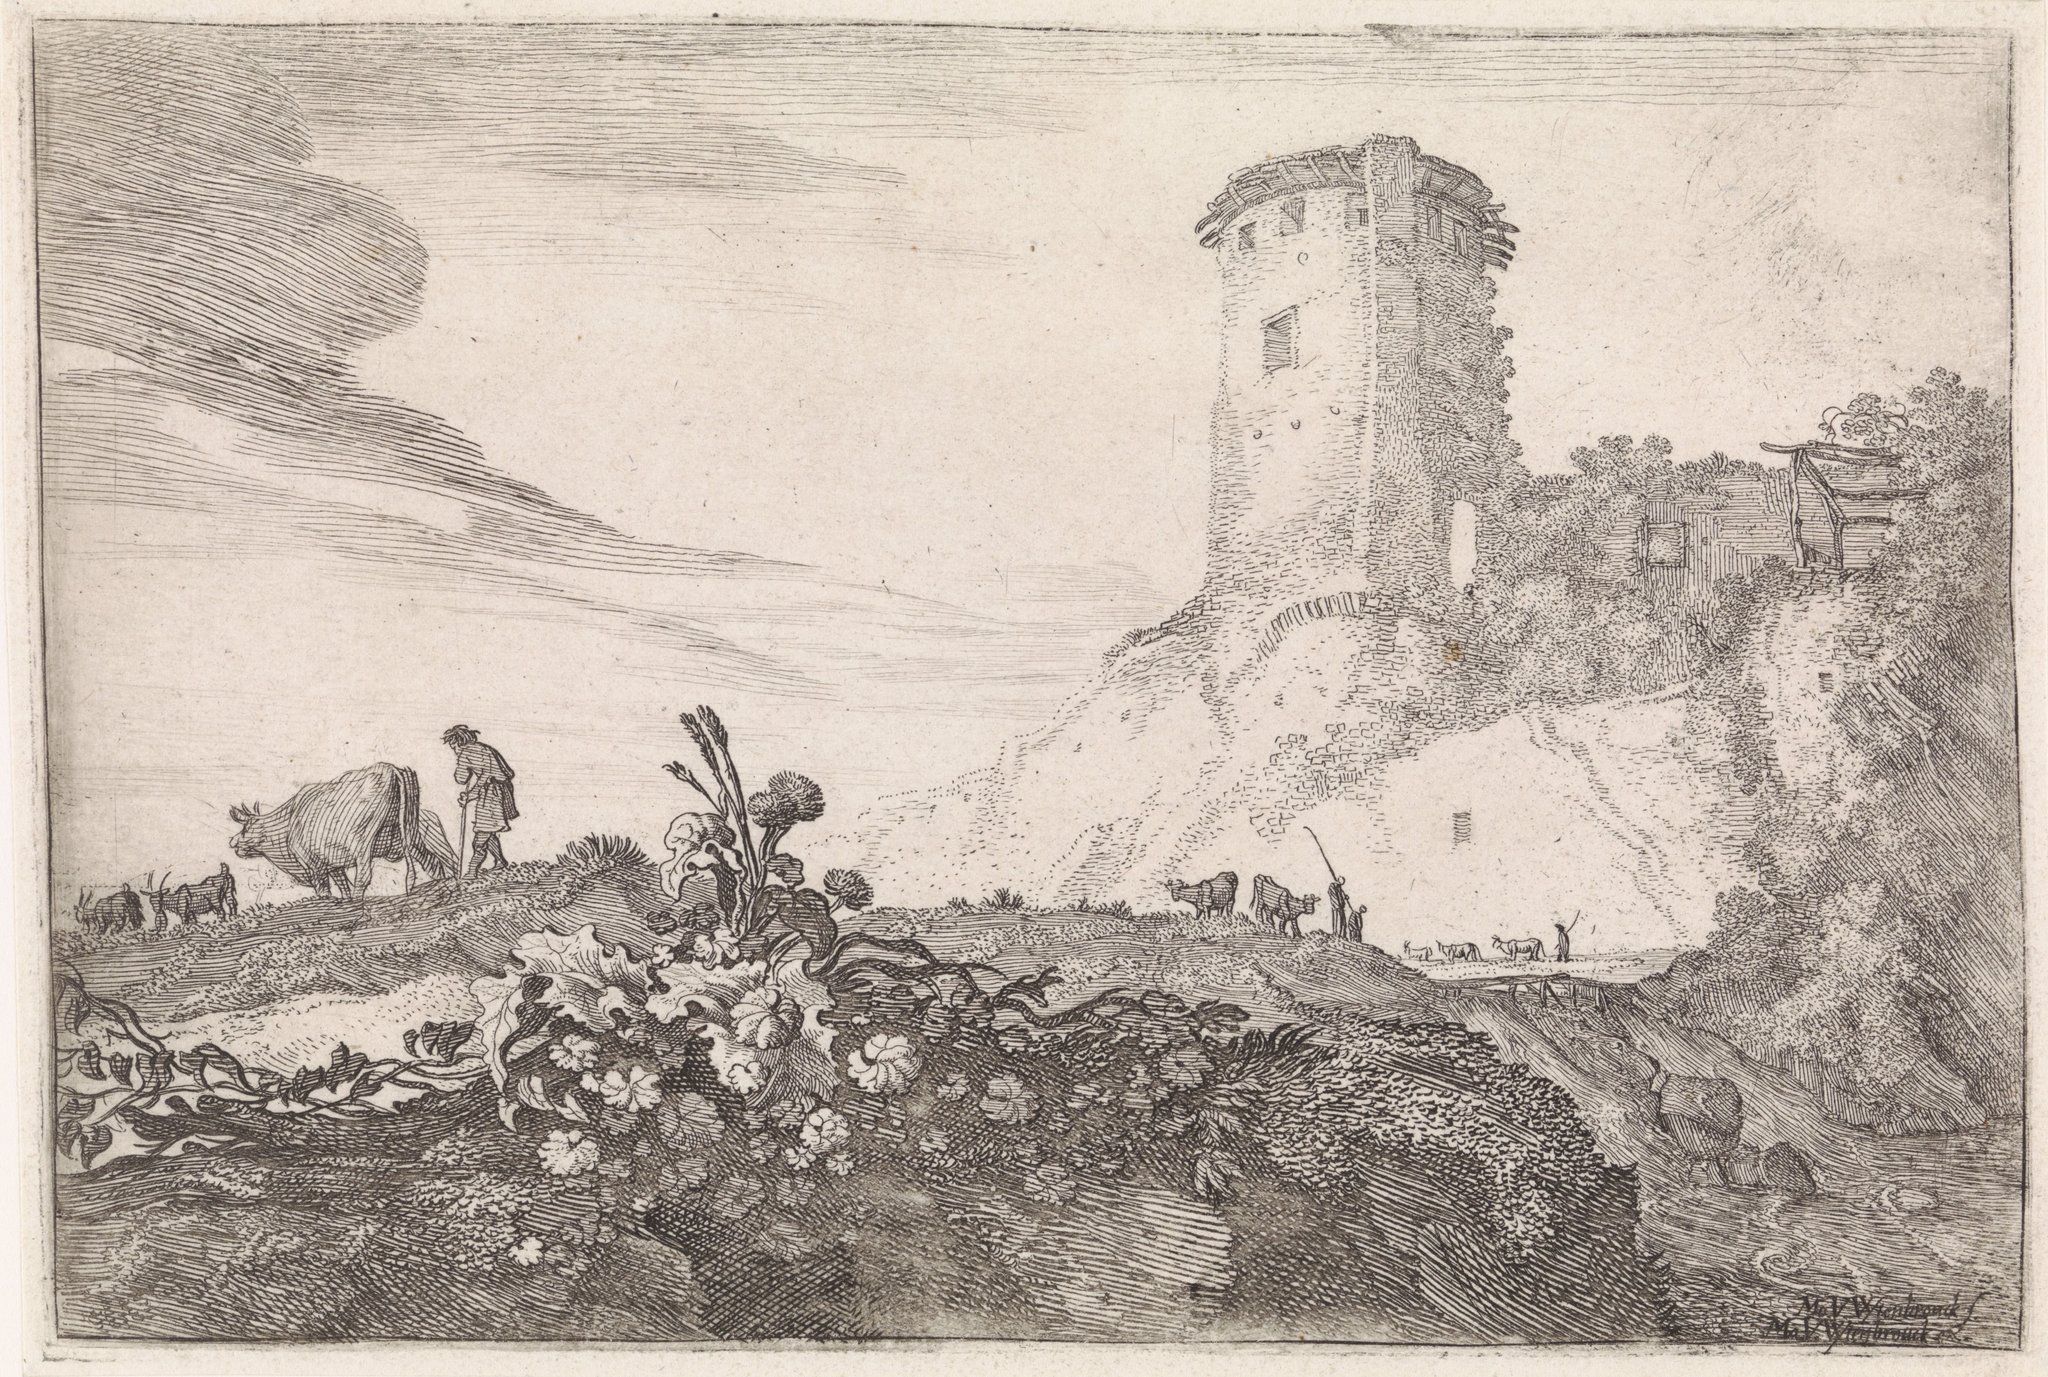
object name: print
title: Arcadische landschappen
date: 1600-1647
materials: paper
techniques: engraving, etching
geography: the hague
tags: landscape with tower or castle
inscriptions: collector's mark: Lugt 240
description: Een groep herders trekt met een kudde koeien en geiten langs een grote ronde toren. Op de voorgrond een bloeiende distel.